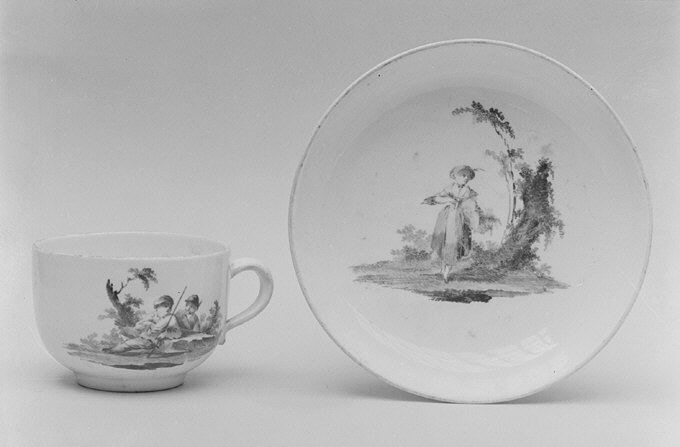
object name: cup and saucer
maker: kloster-veilsdorf porcelain manufactory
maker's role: manufactory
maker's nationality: german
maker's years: 1760-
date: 1770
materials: hard paste porcelain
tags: men,women